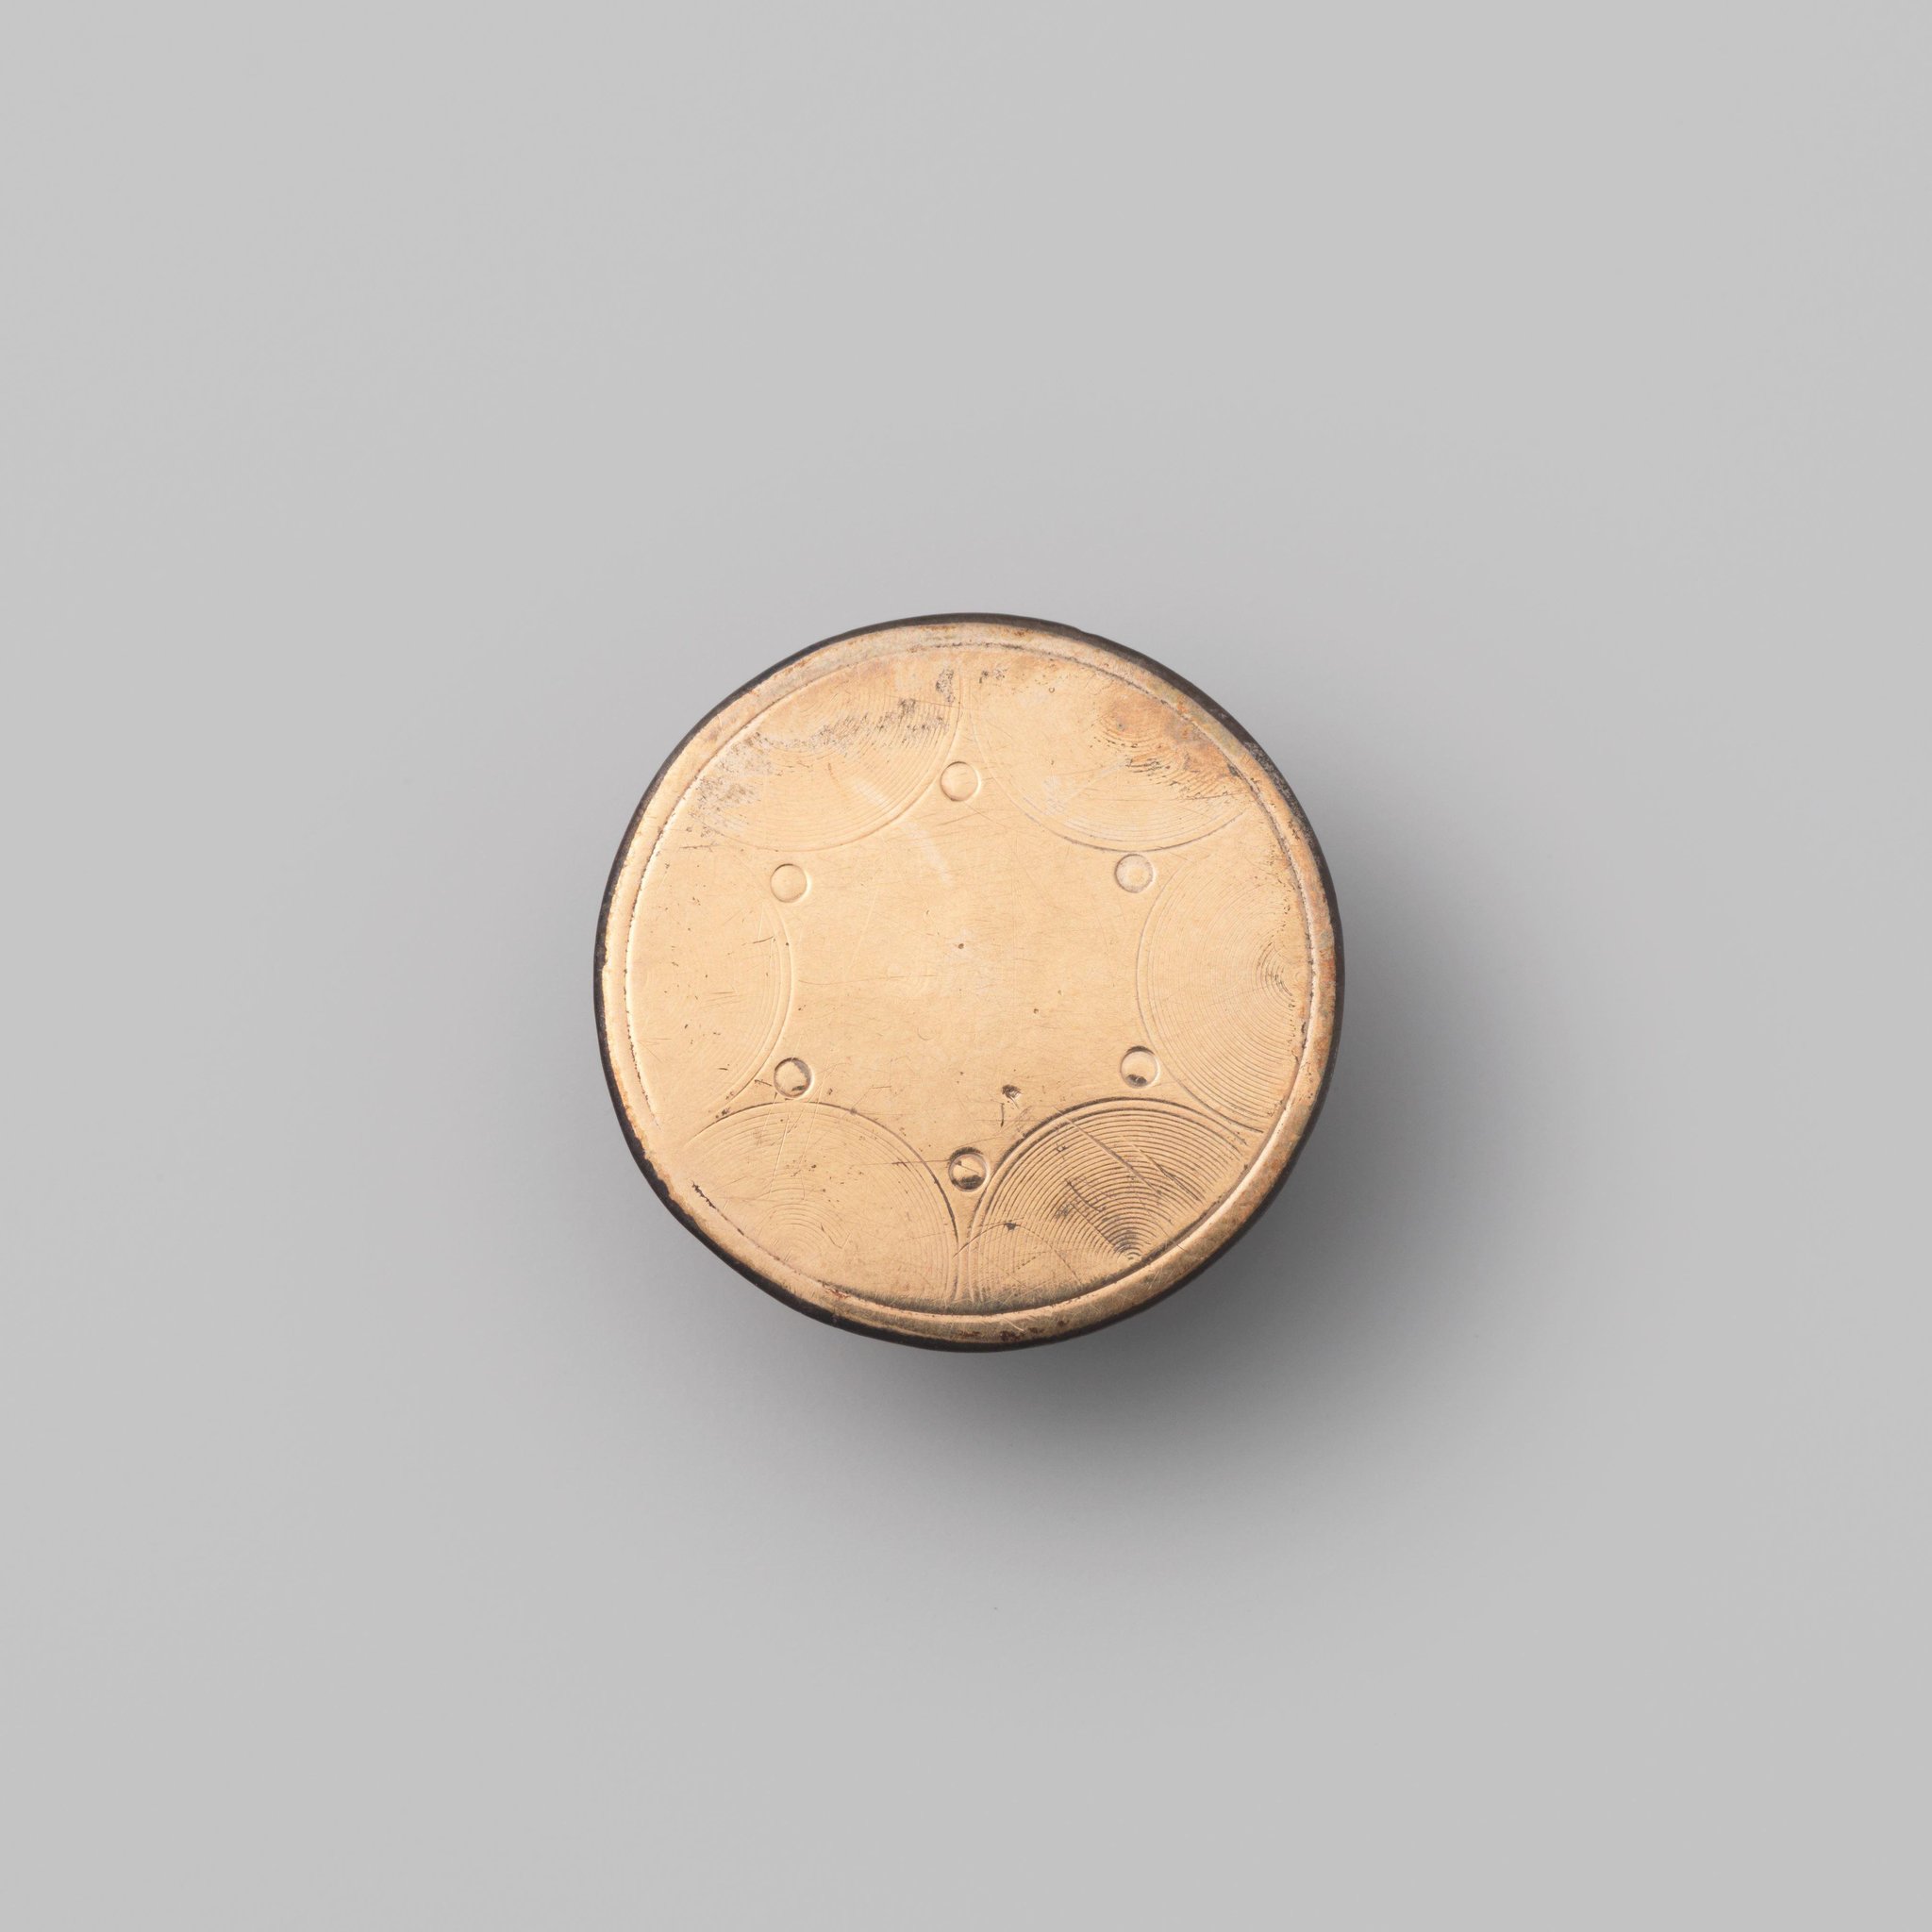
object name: cuff link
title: Platte ronde manchetknoop van verguld zilver, versierd met guilloches van een zespuntige ster met holle zijden, waartegenaan zes cirkelbogen met concentrische arceringen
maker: Anonymous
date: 1850-1900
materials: silver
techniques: engraving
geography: netherlands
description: Platte ronde manchetknoop van verguld zilver, versierd met guilloches van een zespuntige ster met holle zijden, waartegenaan zes cirkelbogen met concentrische arceringen. Ongemerkt.